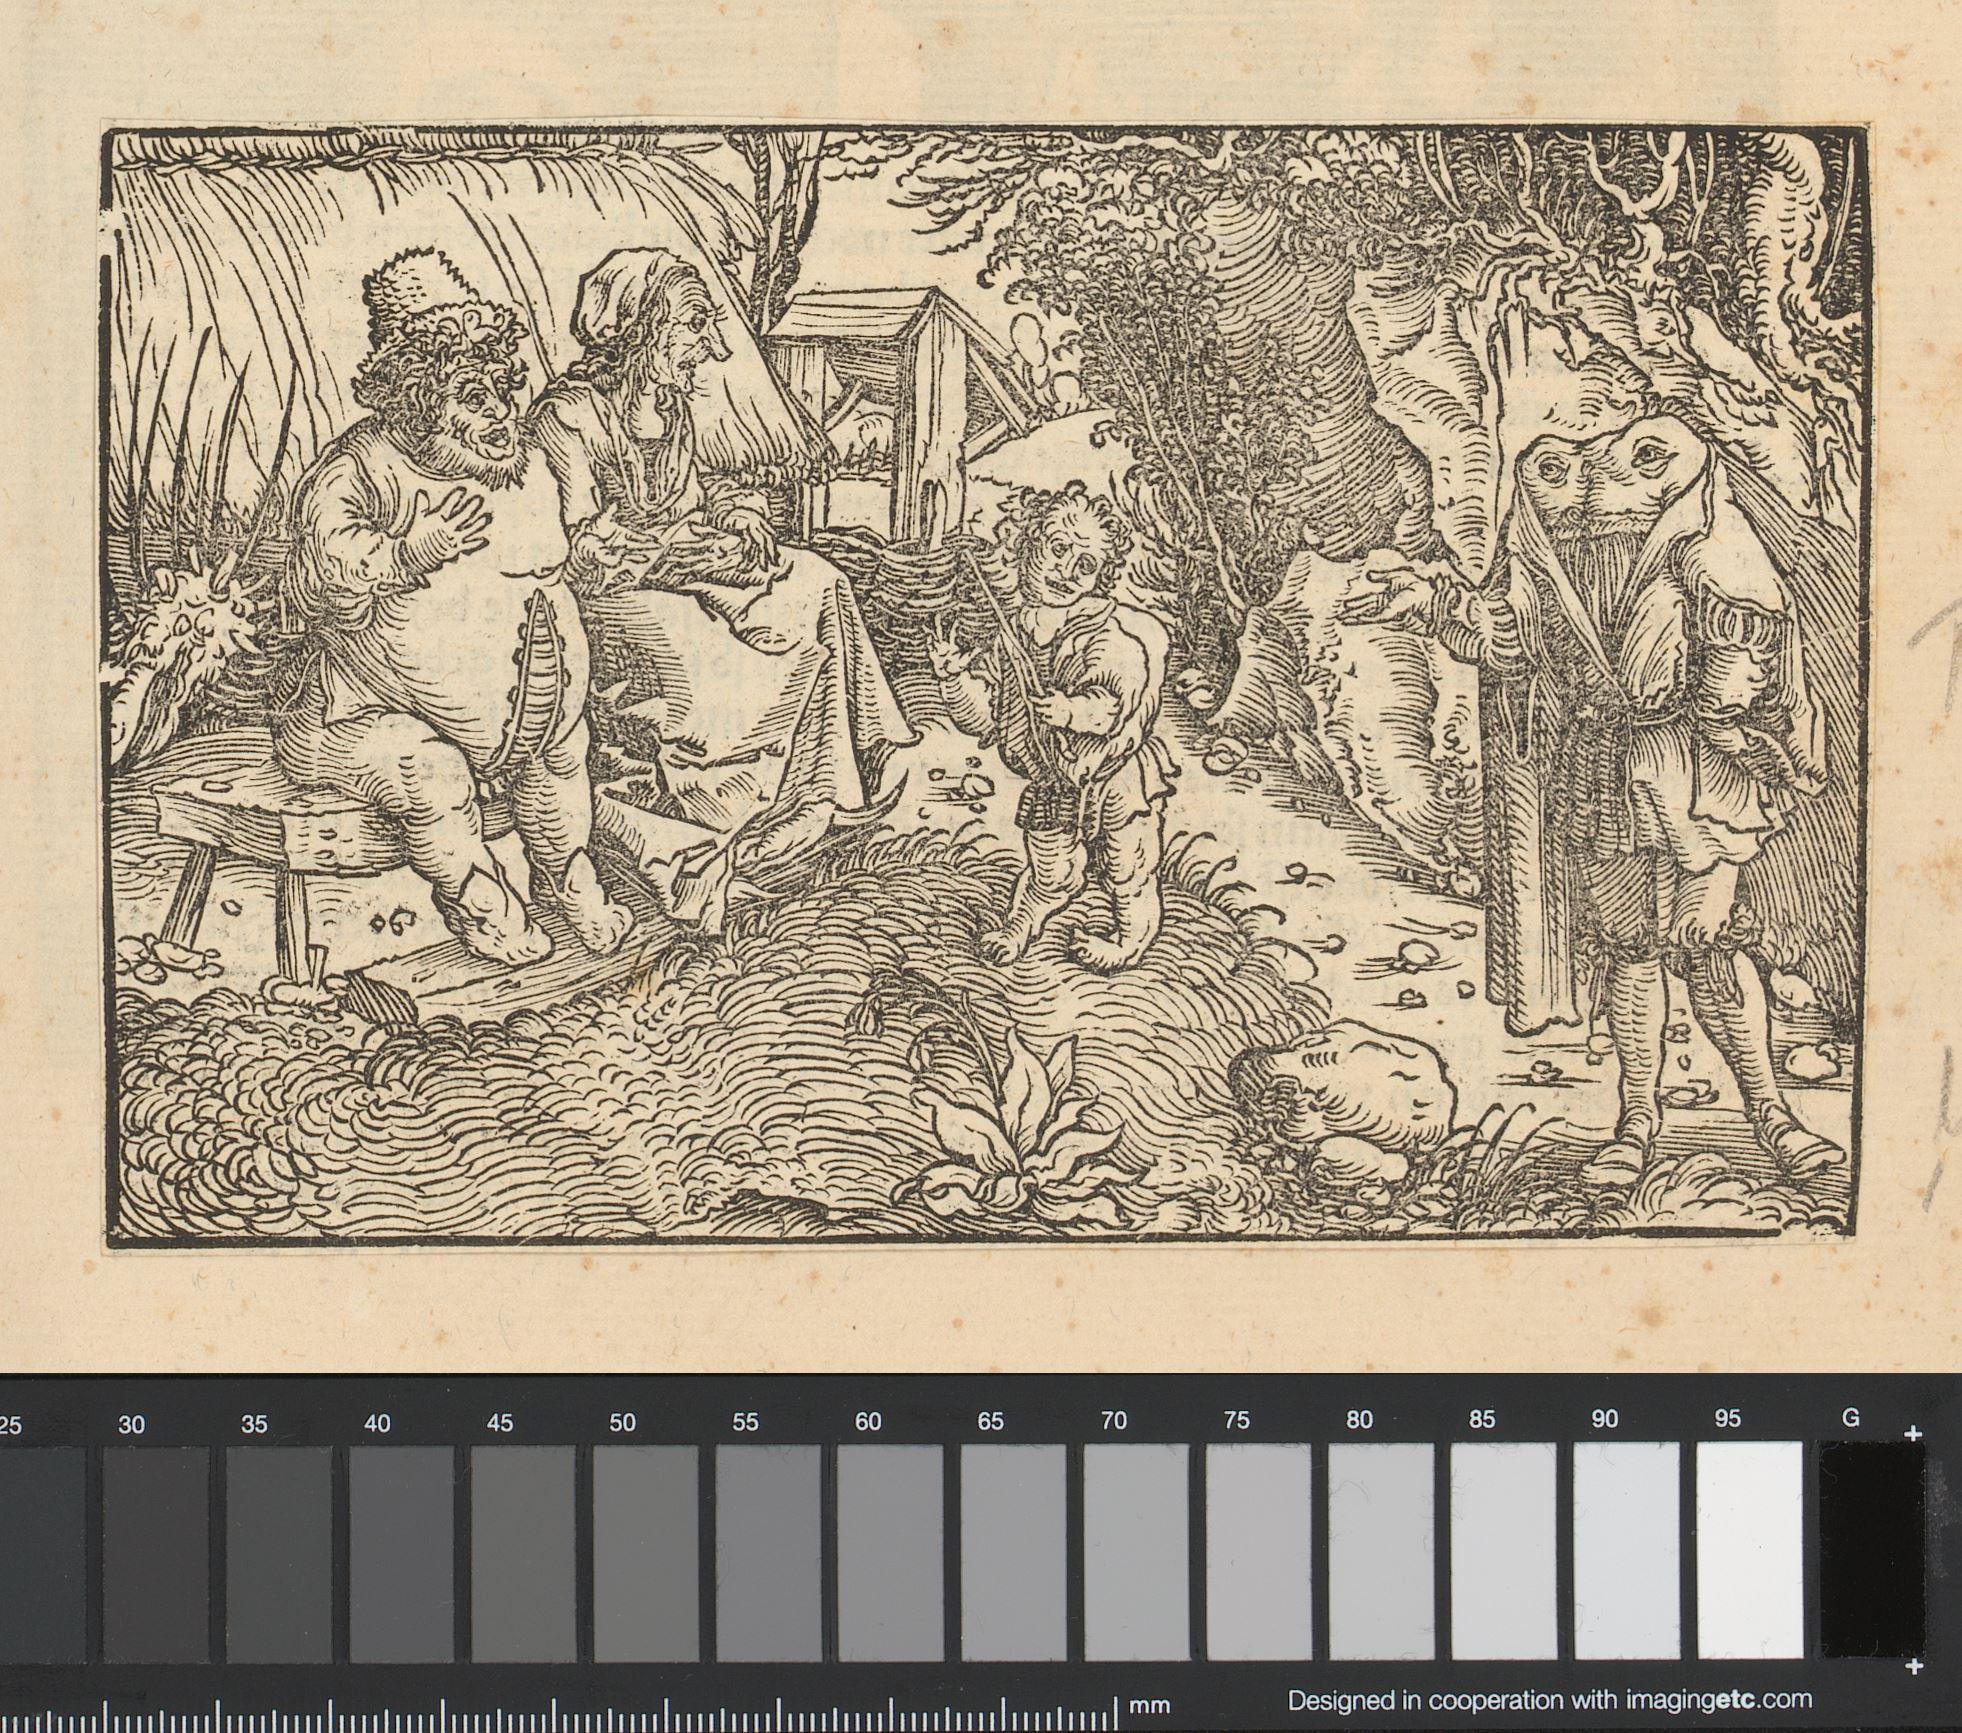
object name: print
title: Familie voor een hut en een hybride man met paddenhoofd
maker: Anonymous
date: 1514-1532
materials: paper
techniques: letterpress printing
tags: ornament ~ hybrid beings; human and animal forms mixed, ugliness, family life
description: Deze prent is gebruikt in: Petrarca, Francesco. Von der Artzney bayder Glück, des guten und widerwertigen: unnd weß sich ain yeder inn Gelück und Unglück halten sol (...). Augsburg: Heinrich Steiner, 1532. Deze uitgave is ook bekend onder de titel 'Trostspiegel in Glück und Unglück'.